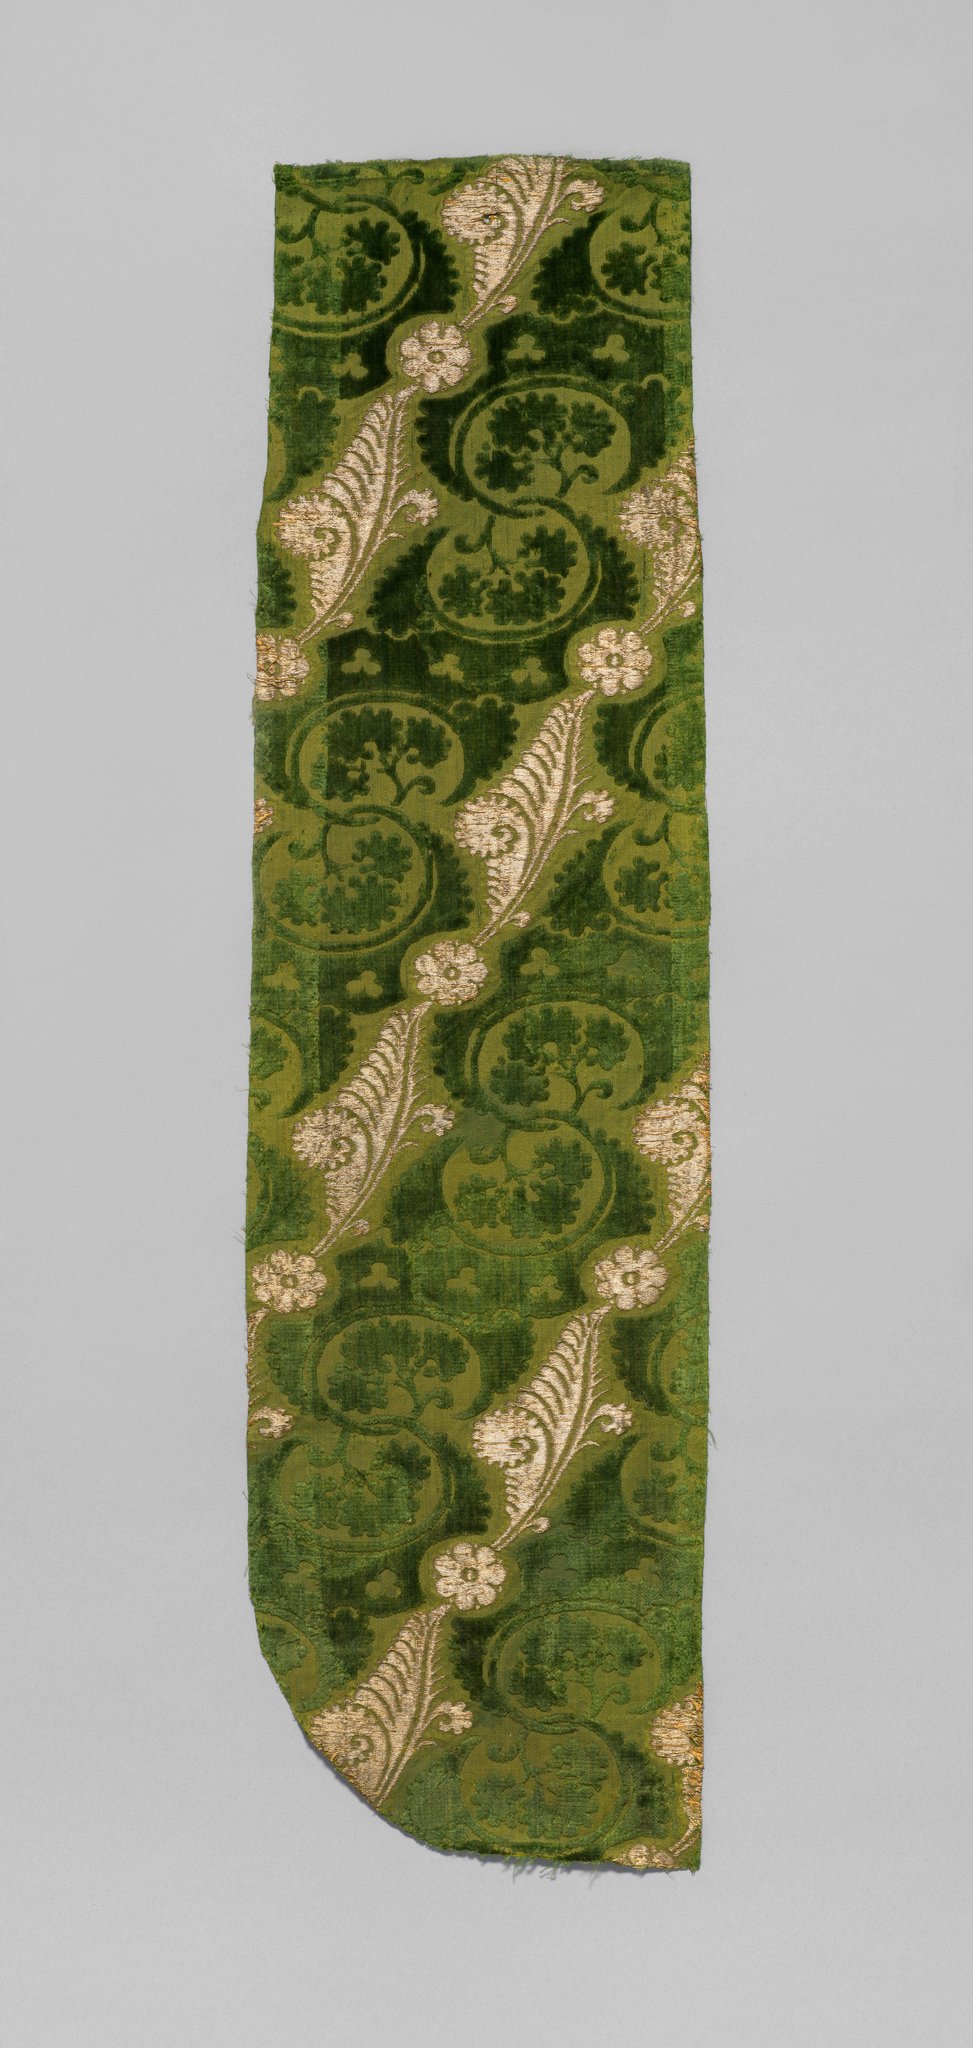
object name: piece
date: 1434-1466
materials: metal thread, silk